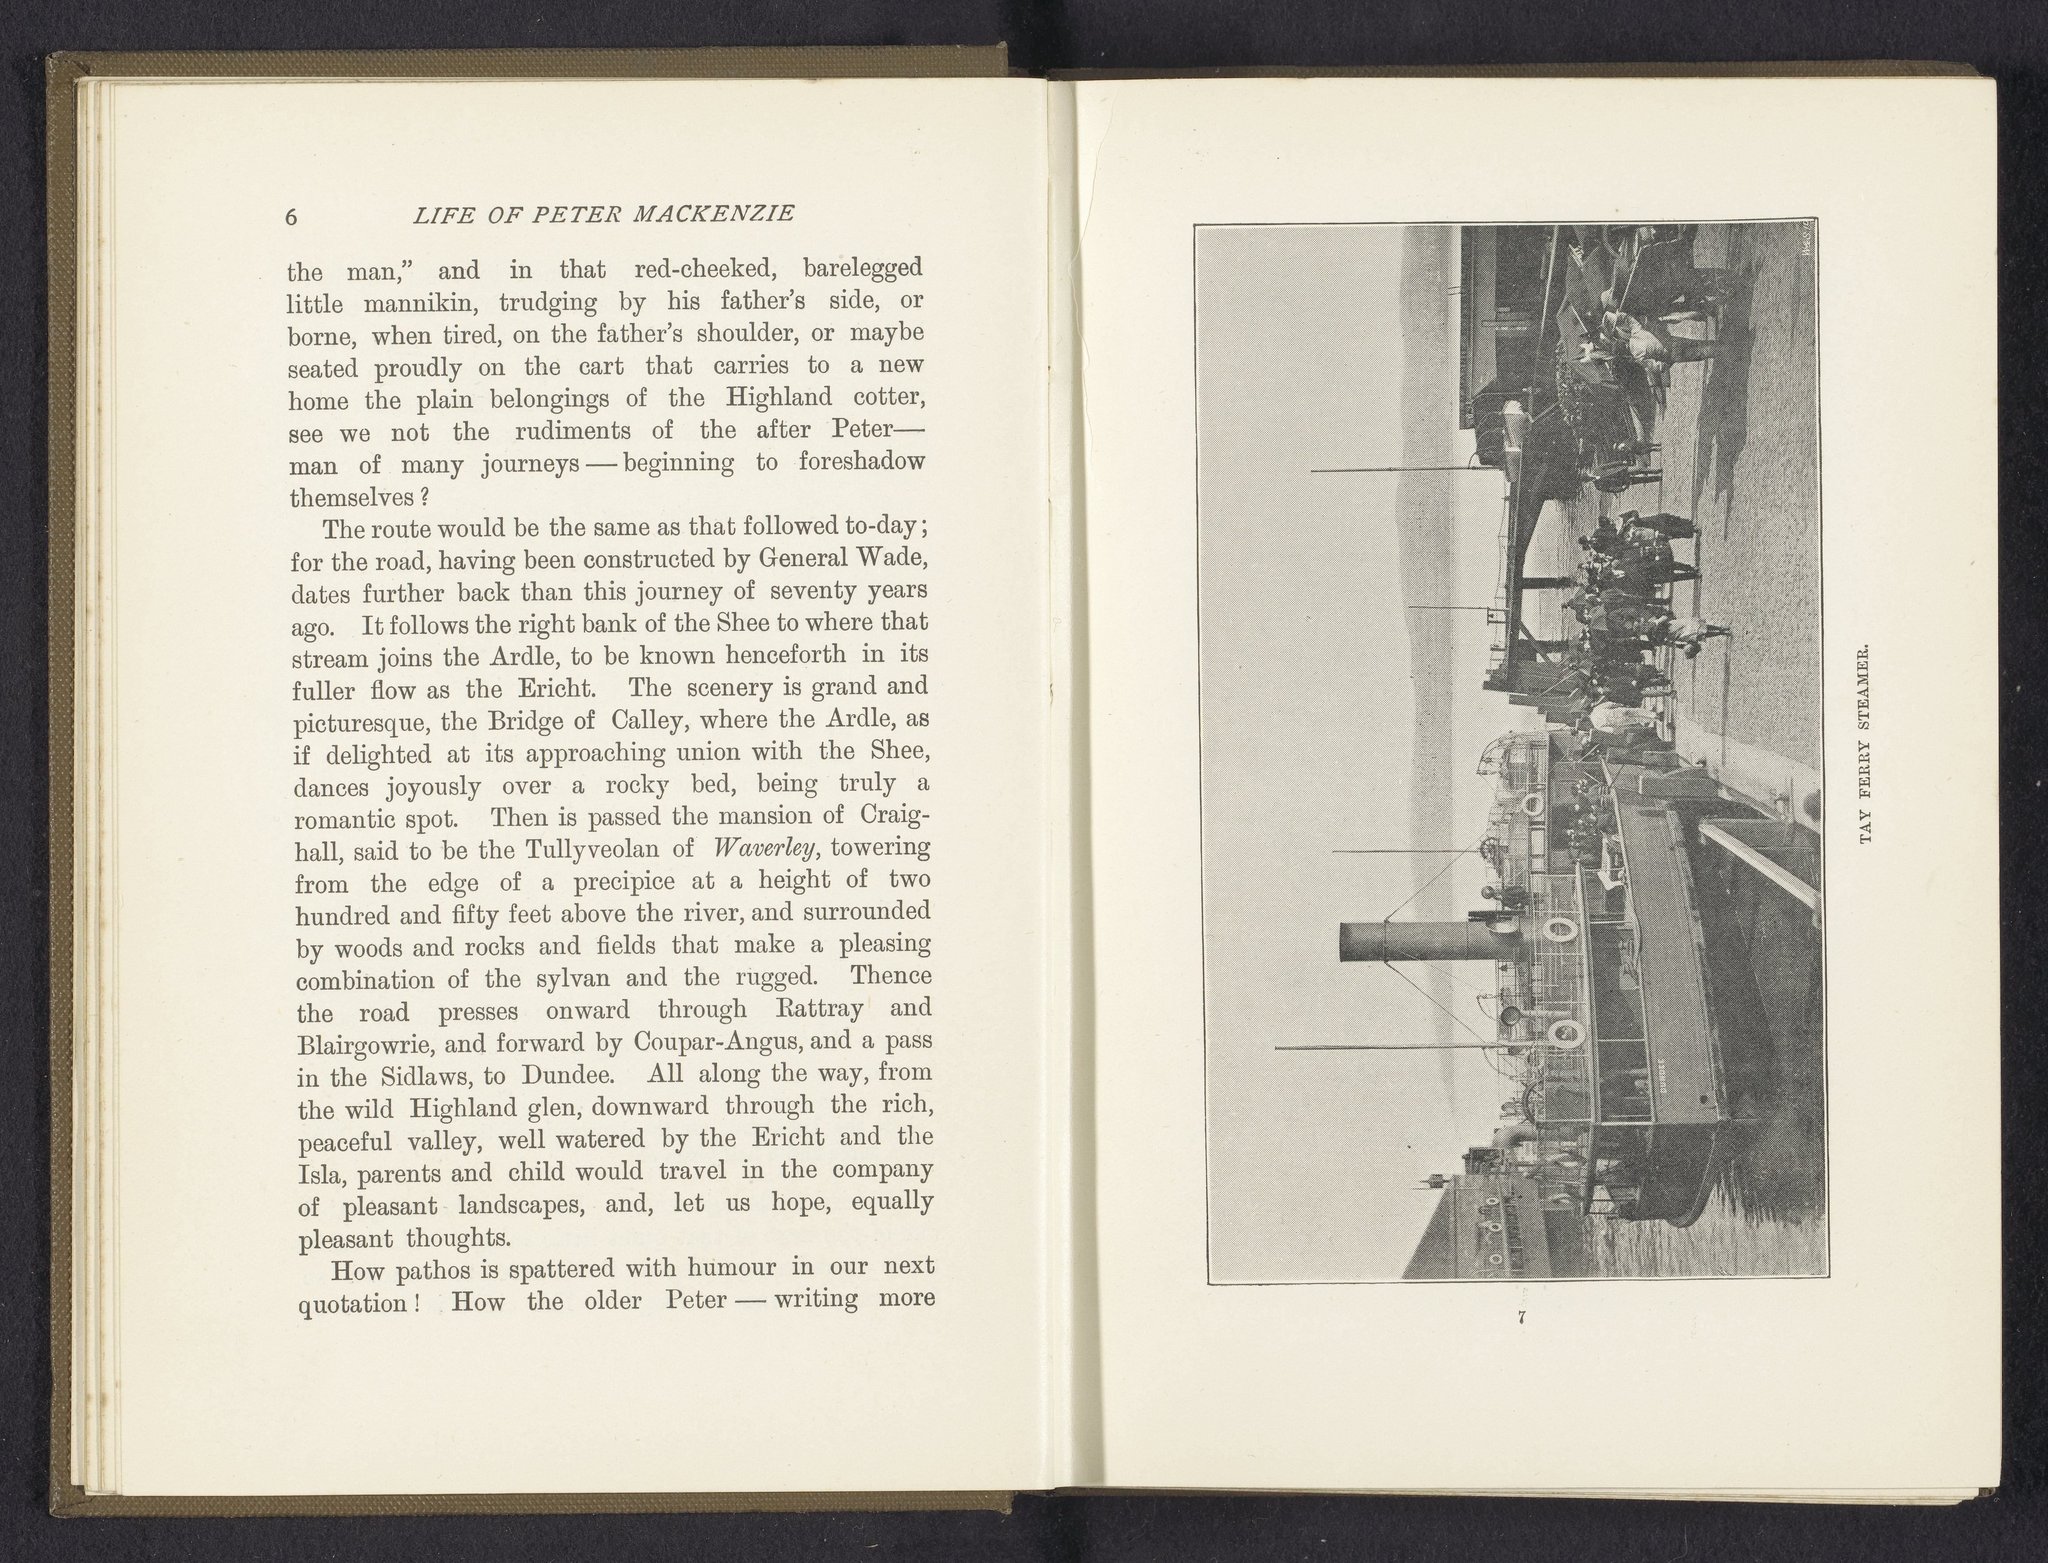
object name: page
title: Tay ferry steamer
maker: Anonymous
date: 1887-1897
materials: paper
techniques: autotype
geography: scotland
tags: river, steamship, motorship